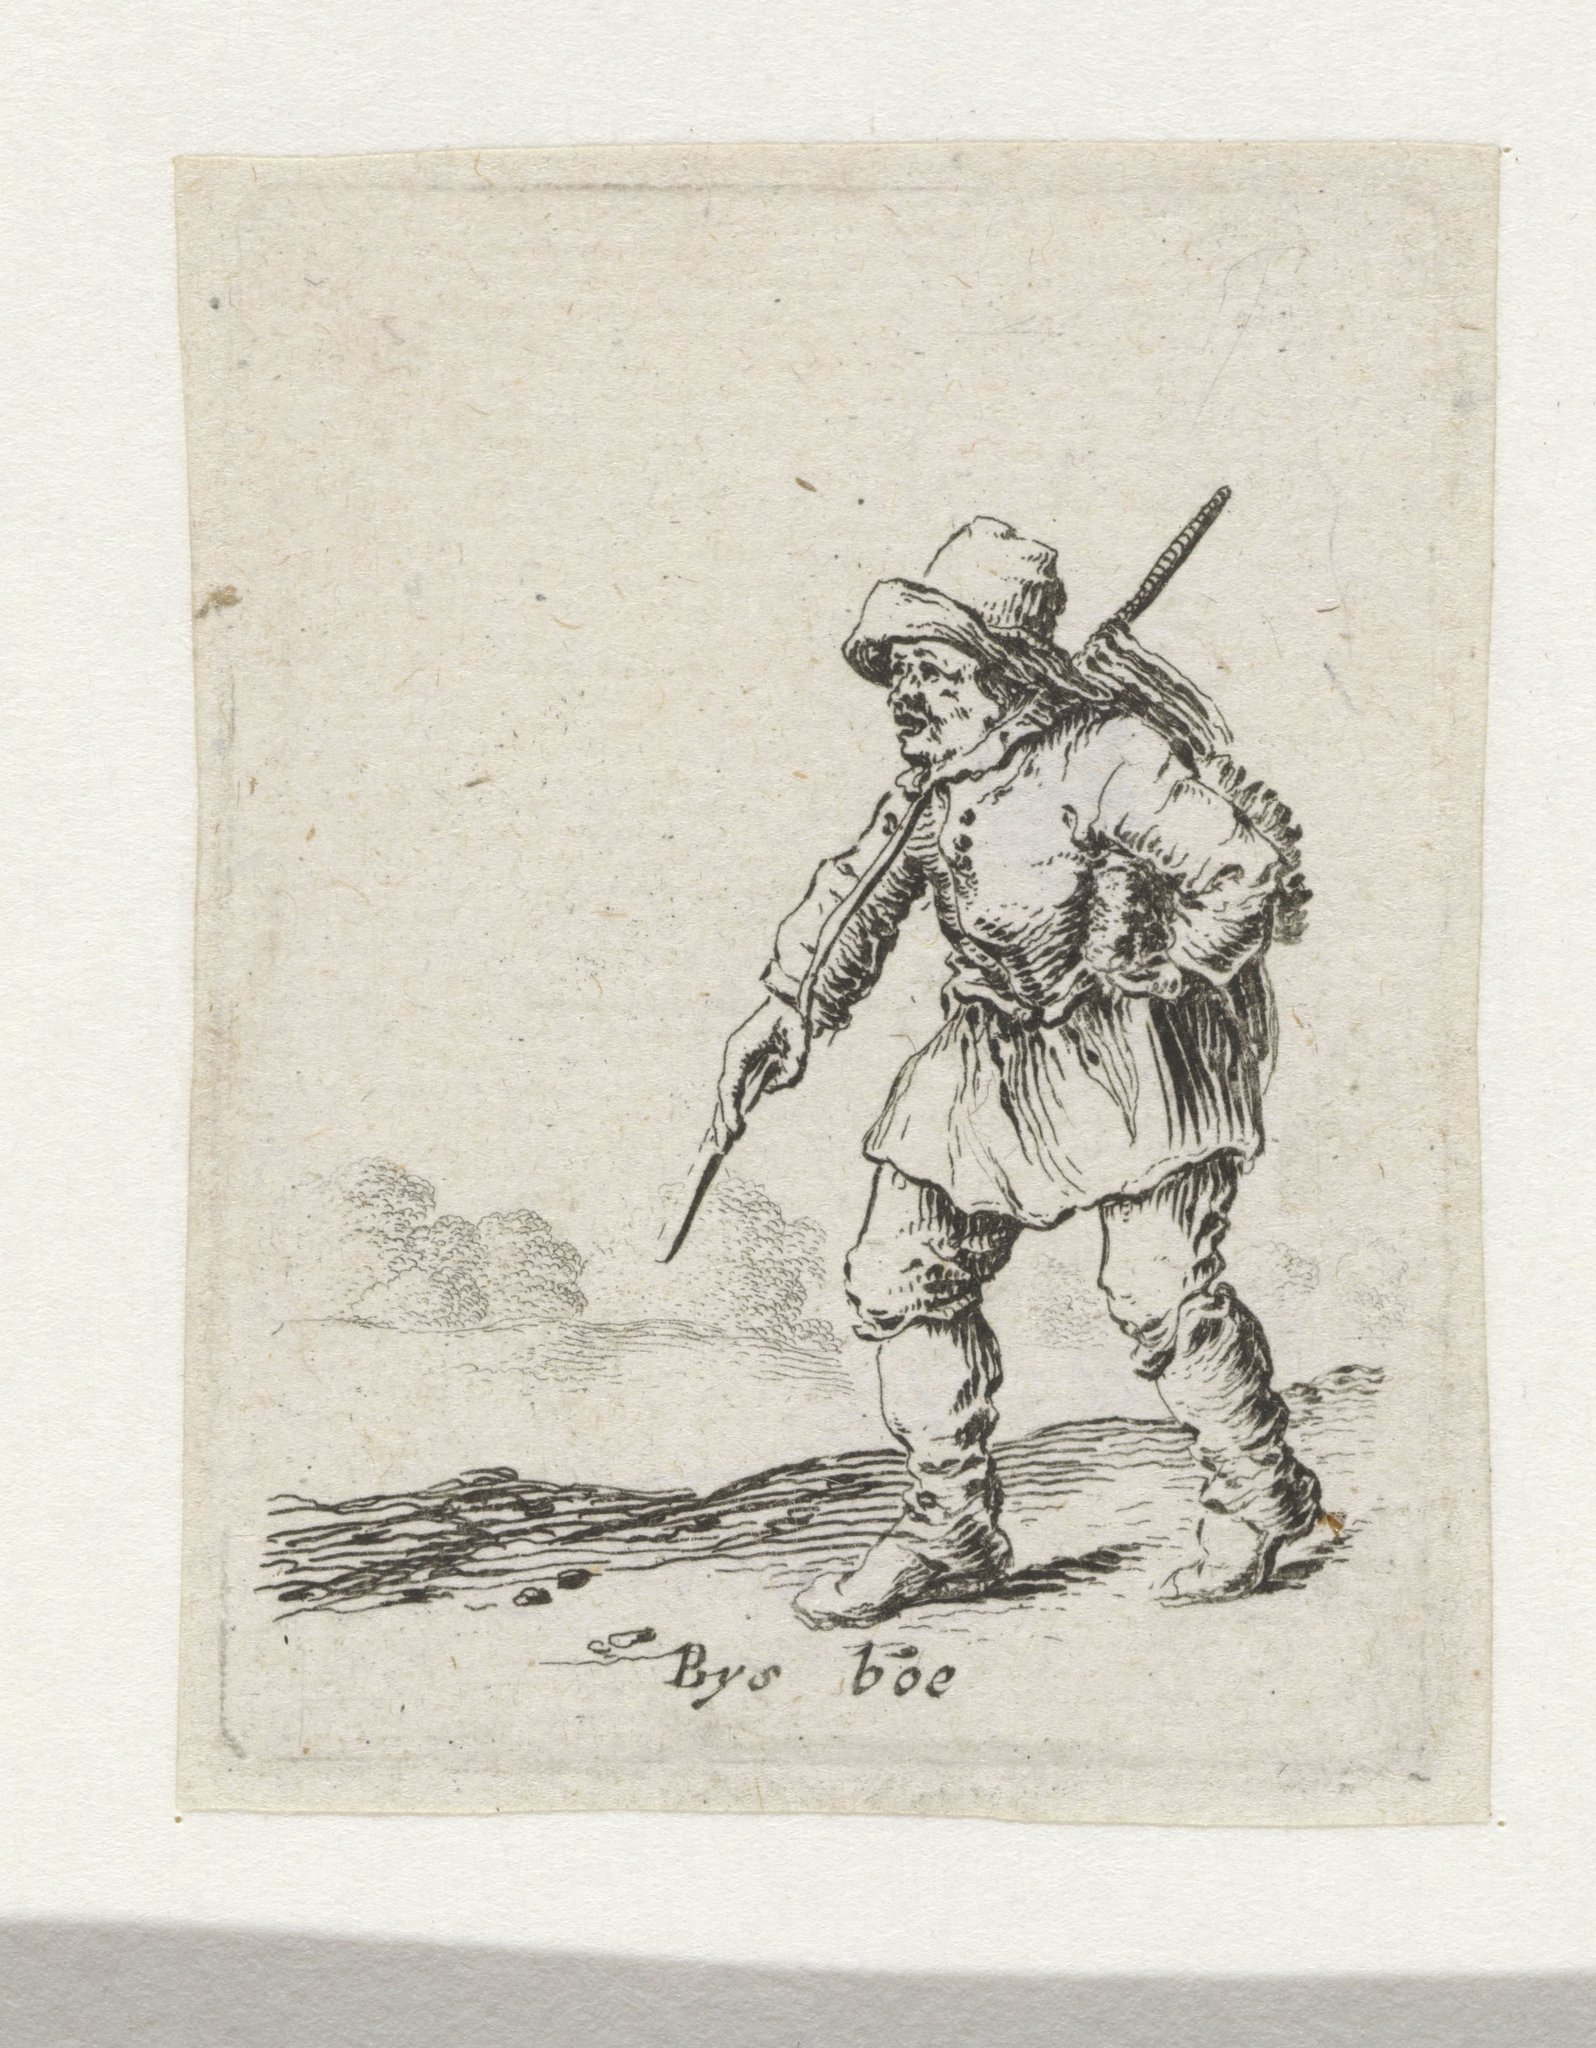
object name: print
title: Genretaferelen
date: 1638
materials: paper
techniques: etching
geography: amsterdam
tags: farmers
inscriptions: collector's mark: Lugt 2760, collector's mark: Lugt 2228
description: Een boer (Bys boe) met een hoed op het hoofd en een stok op zijn schouder loopt naar links. De prent maakt deel uit van een serie van 32 prenten met genretaferelen.